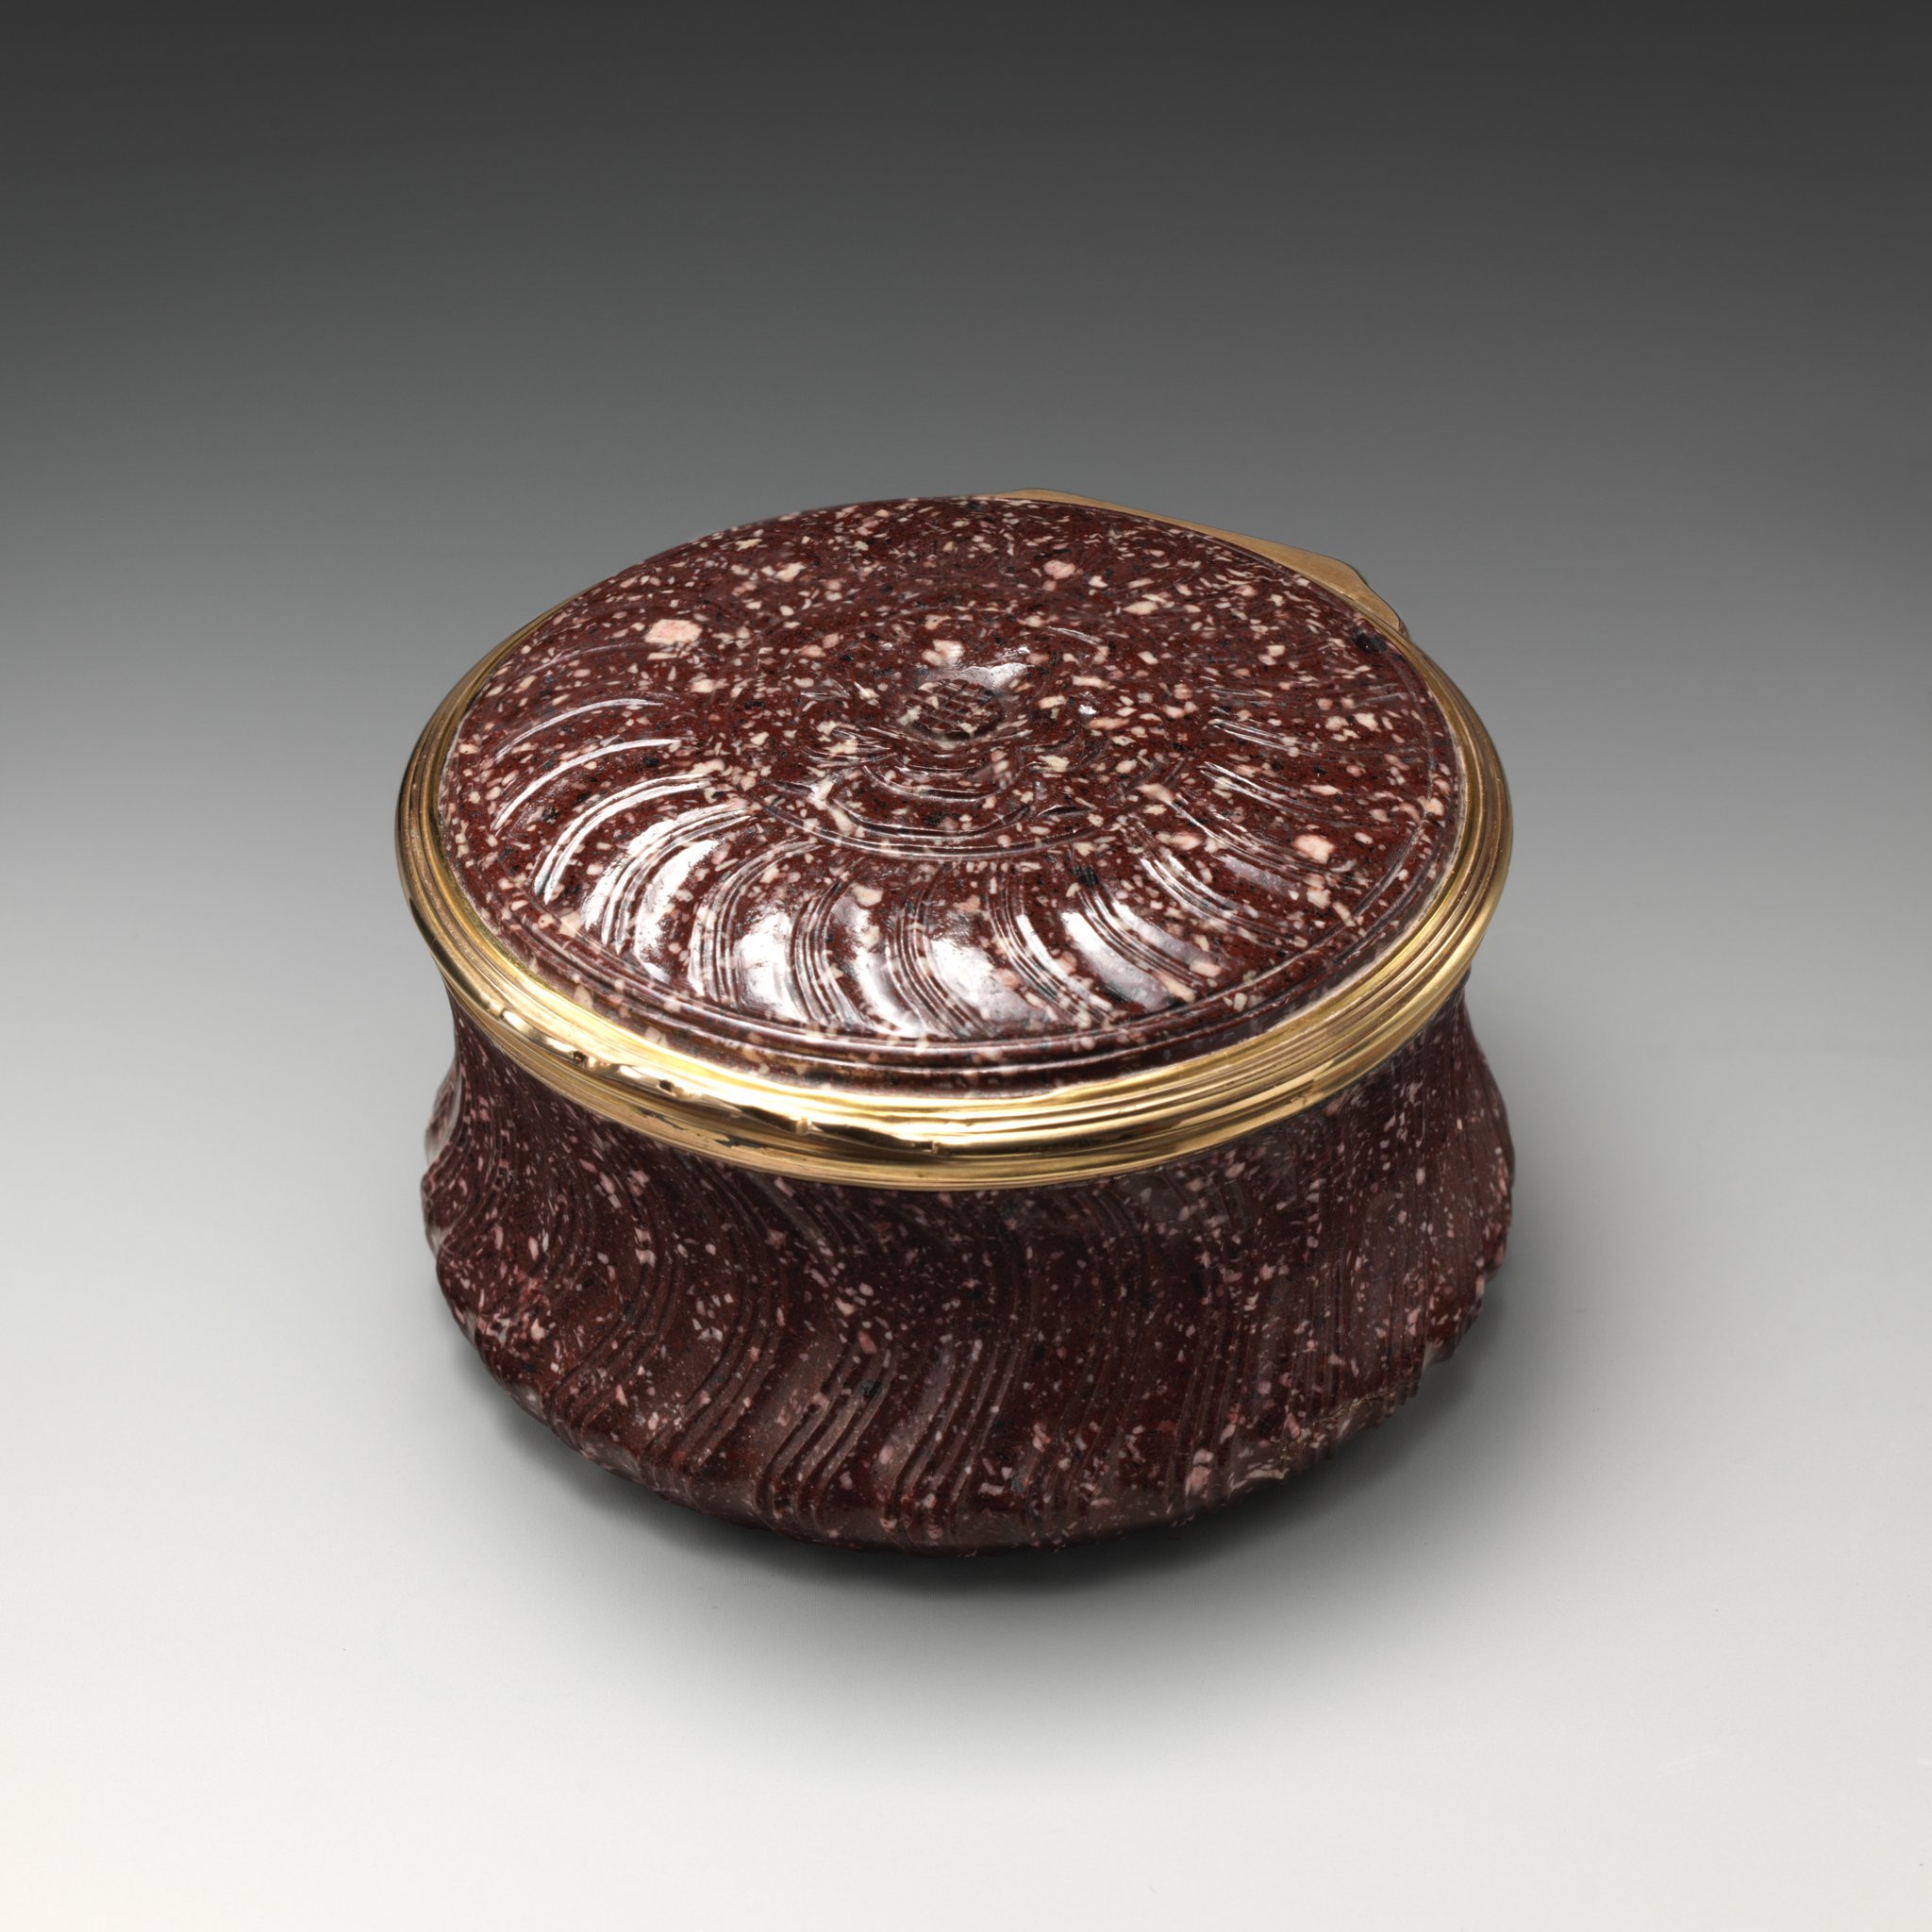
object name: box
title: Round box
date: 1770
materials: gold